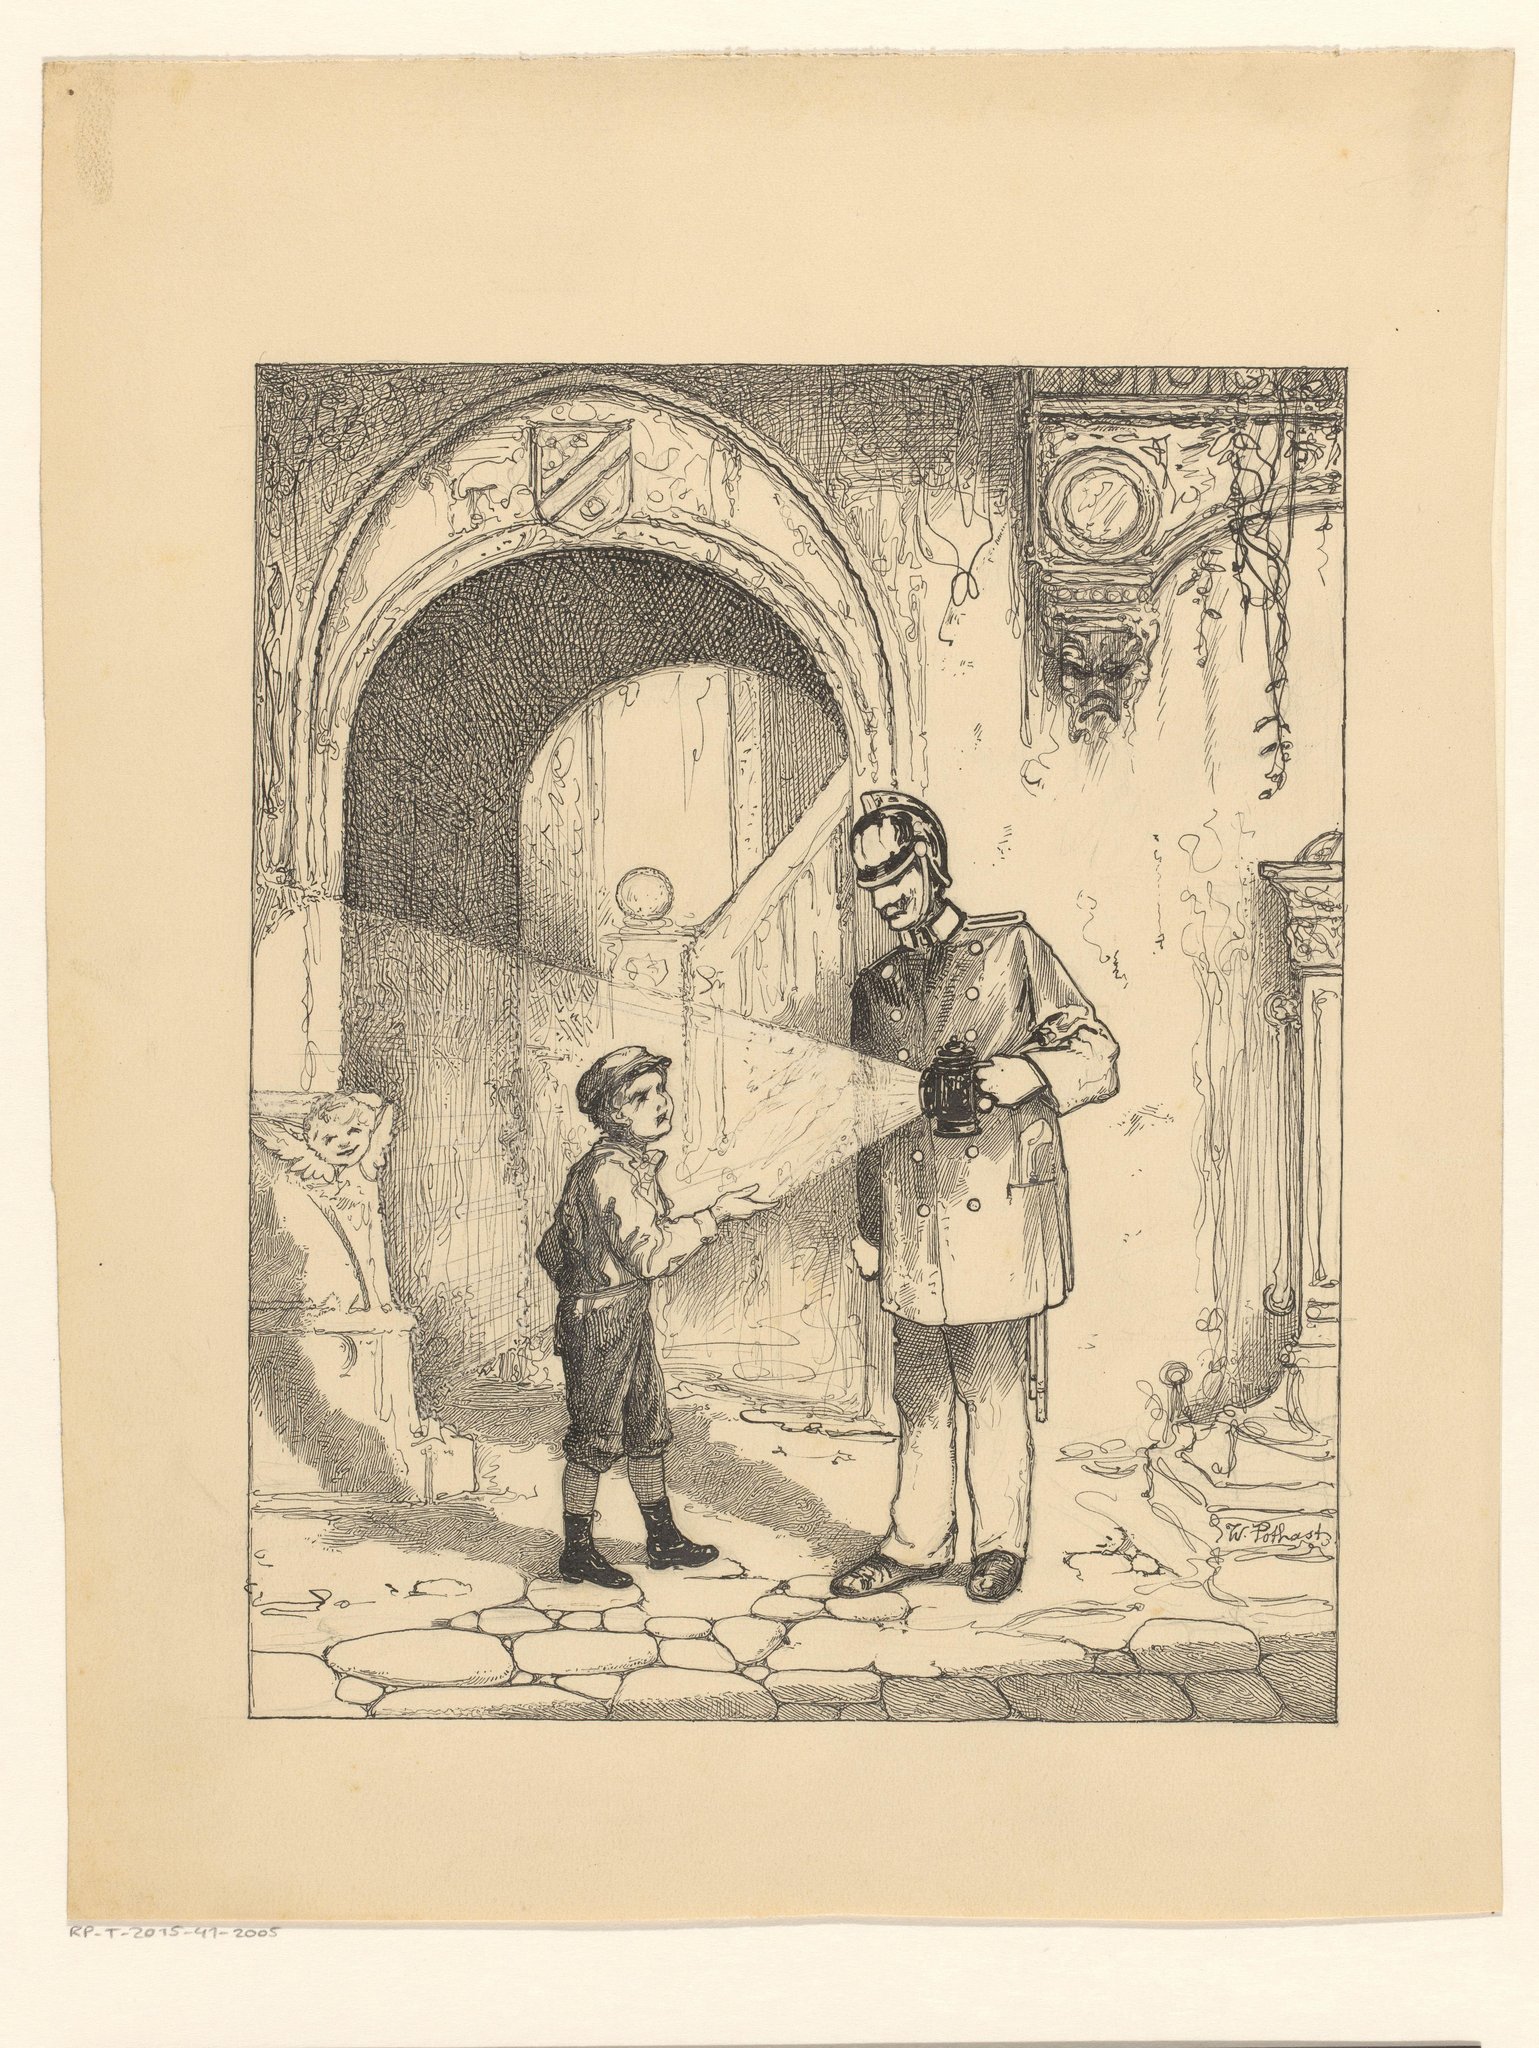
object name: drawing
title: Jongen en politieman op een straat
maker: willem pothast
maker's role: draughtsman, print maker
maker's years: 1877-1916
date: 1887-1916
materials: ink, paper, pencil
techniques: pen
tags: boy (child between toddler and youth), policeman, constable, street (+ city(-scape) with figures, staffage)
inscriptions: signature: ‘W. Pothast.’, collector's mark: Lugt 2228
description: Een politieman staat op straat bij een poort. Met een lantaarn schijnt hij op het gezicht van een jongen.